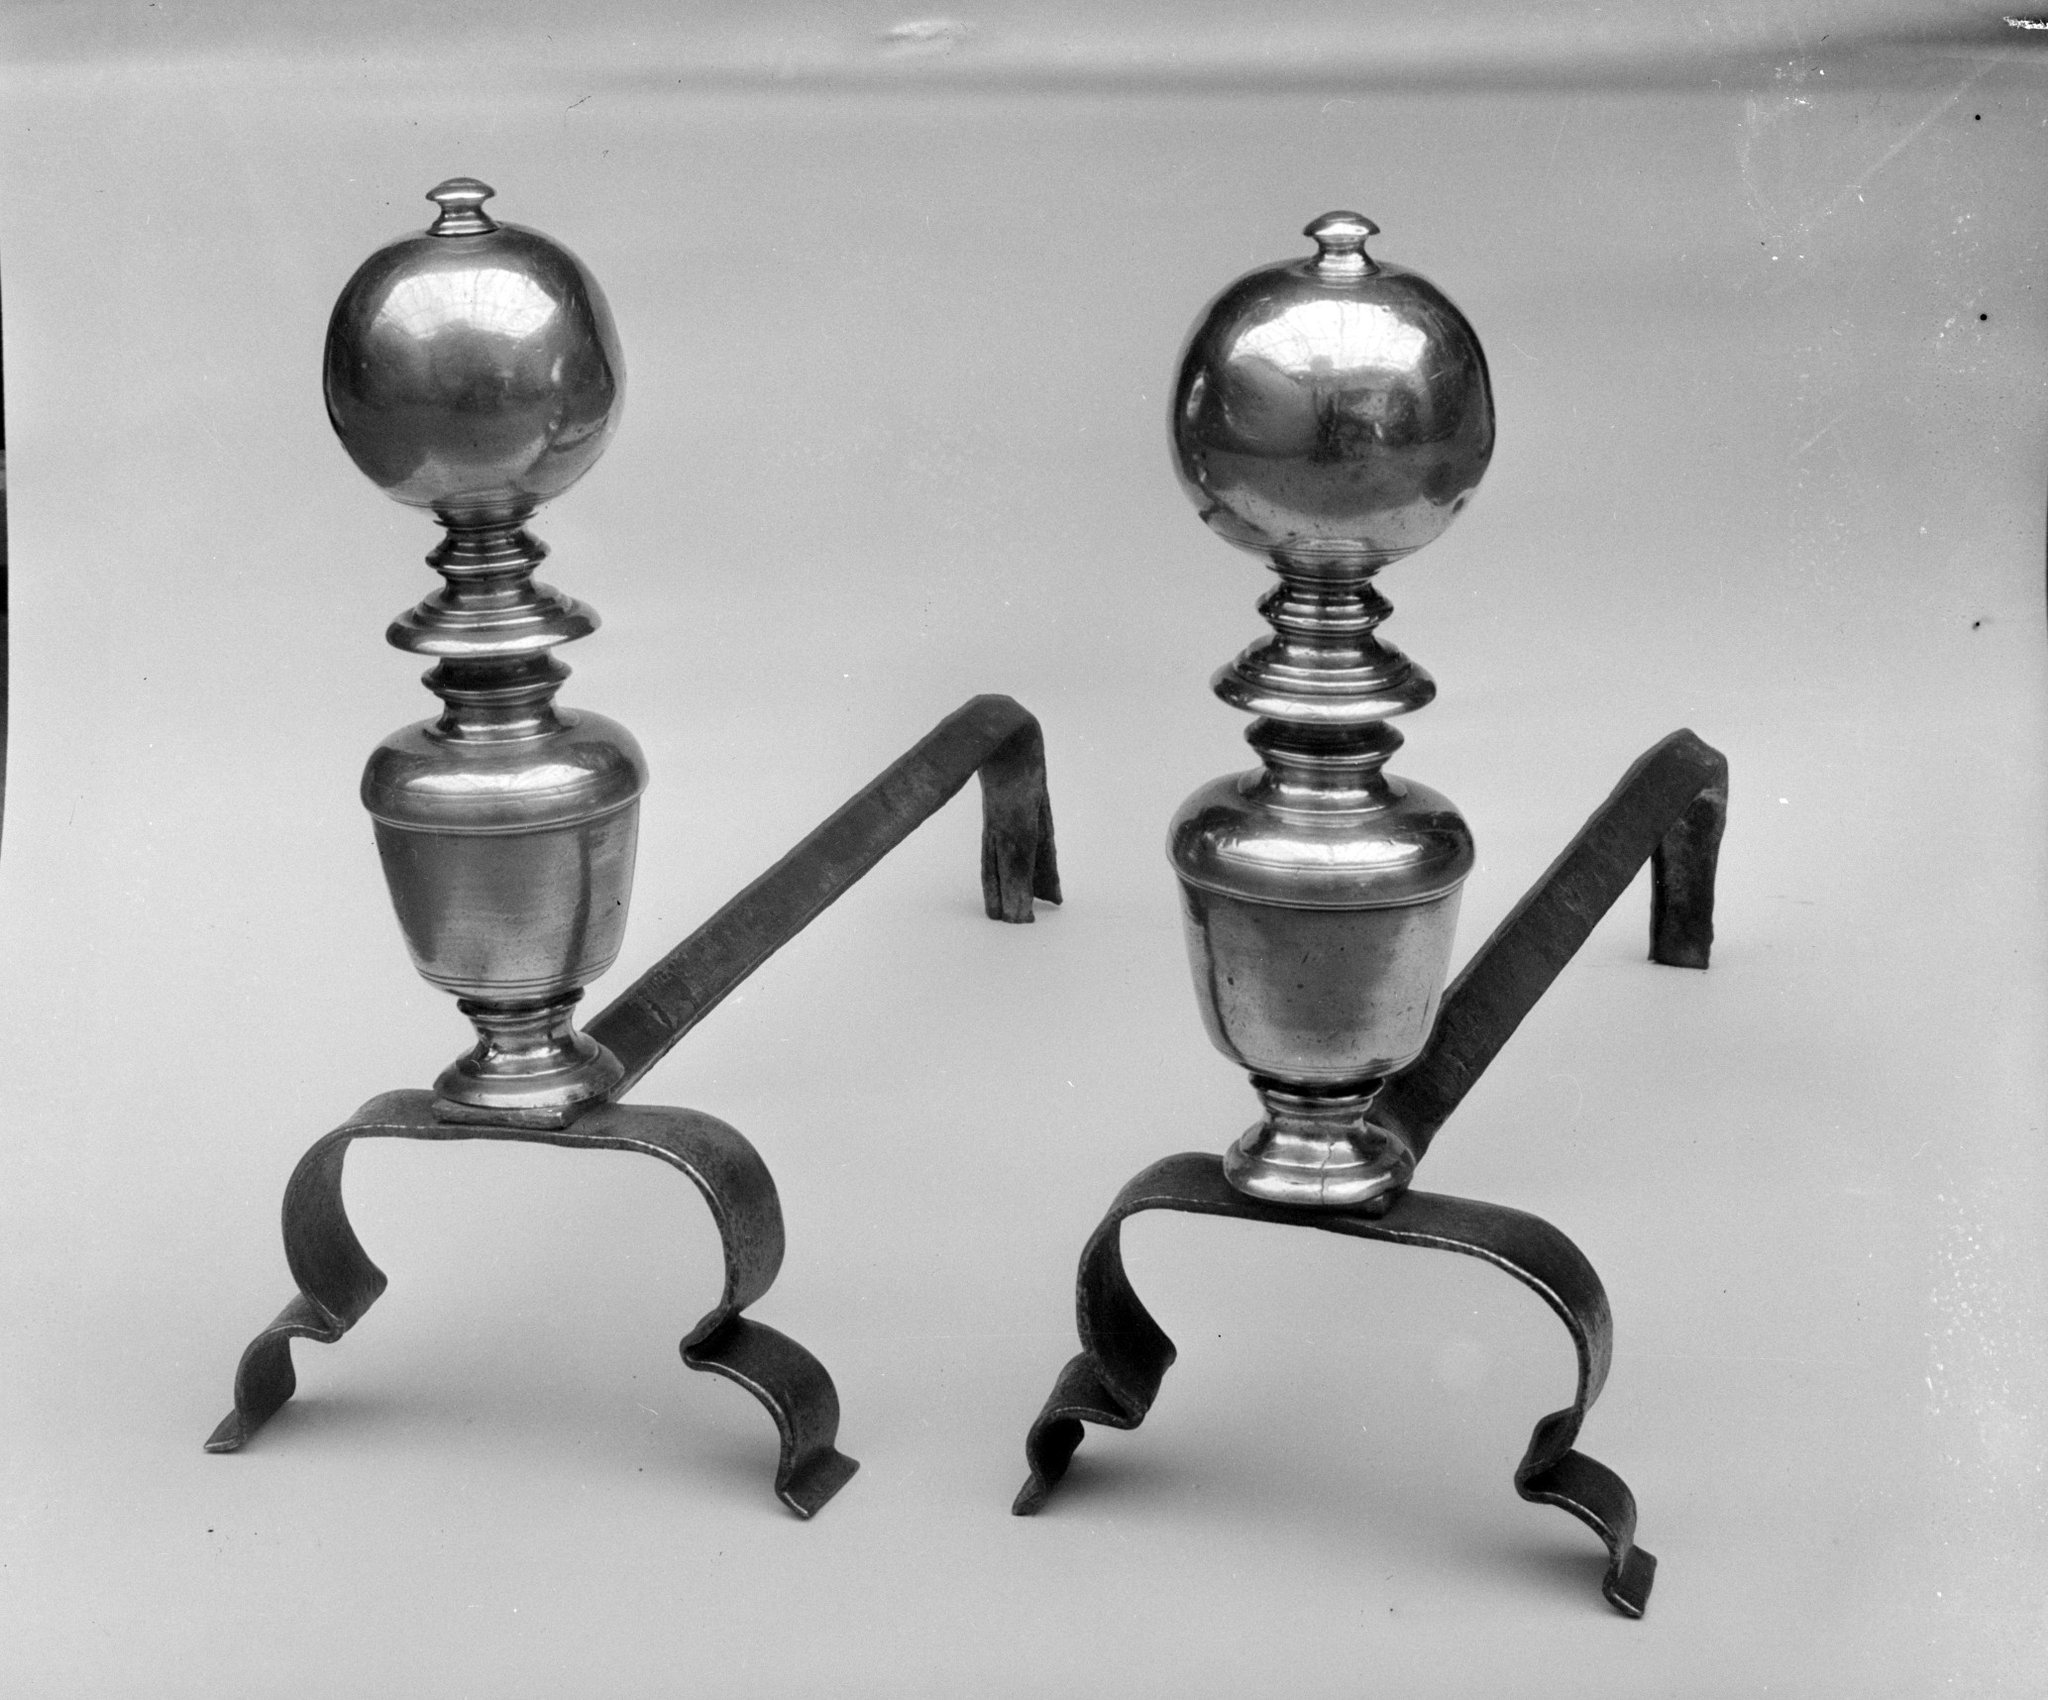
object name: andiron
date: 1700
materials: brass, iron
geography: spain